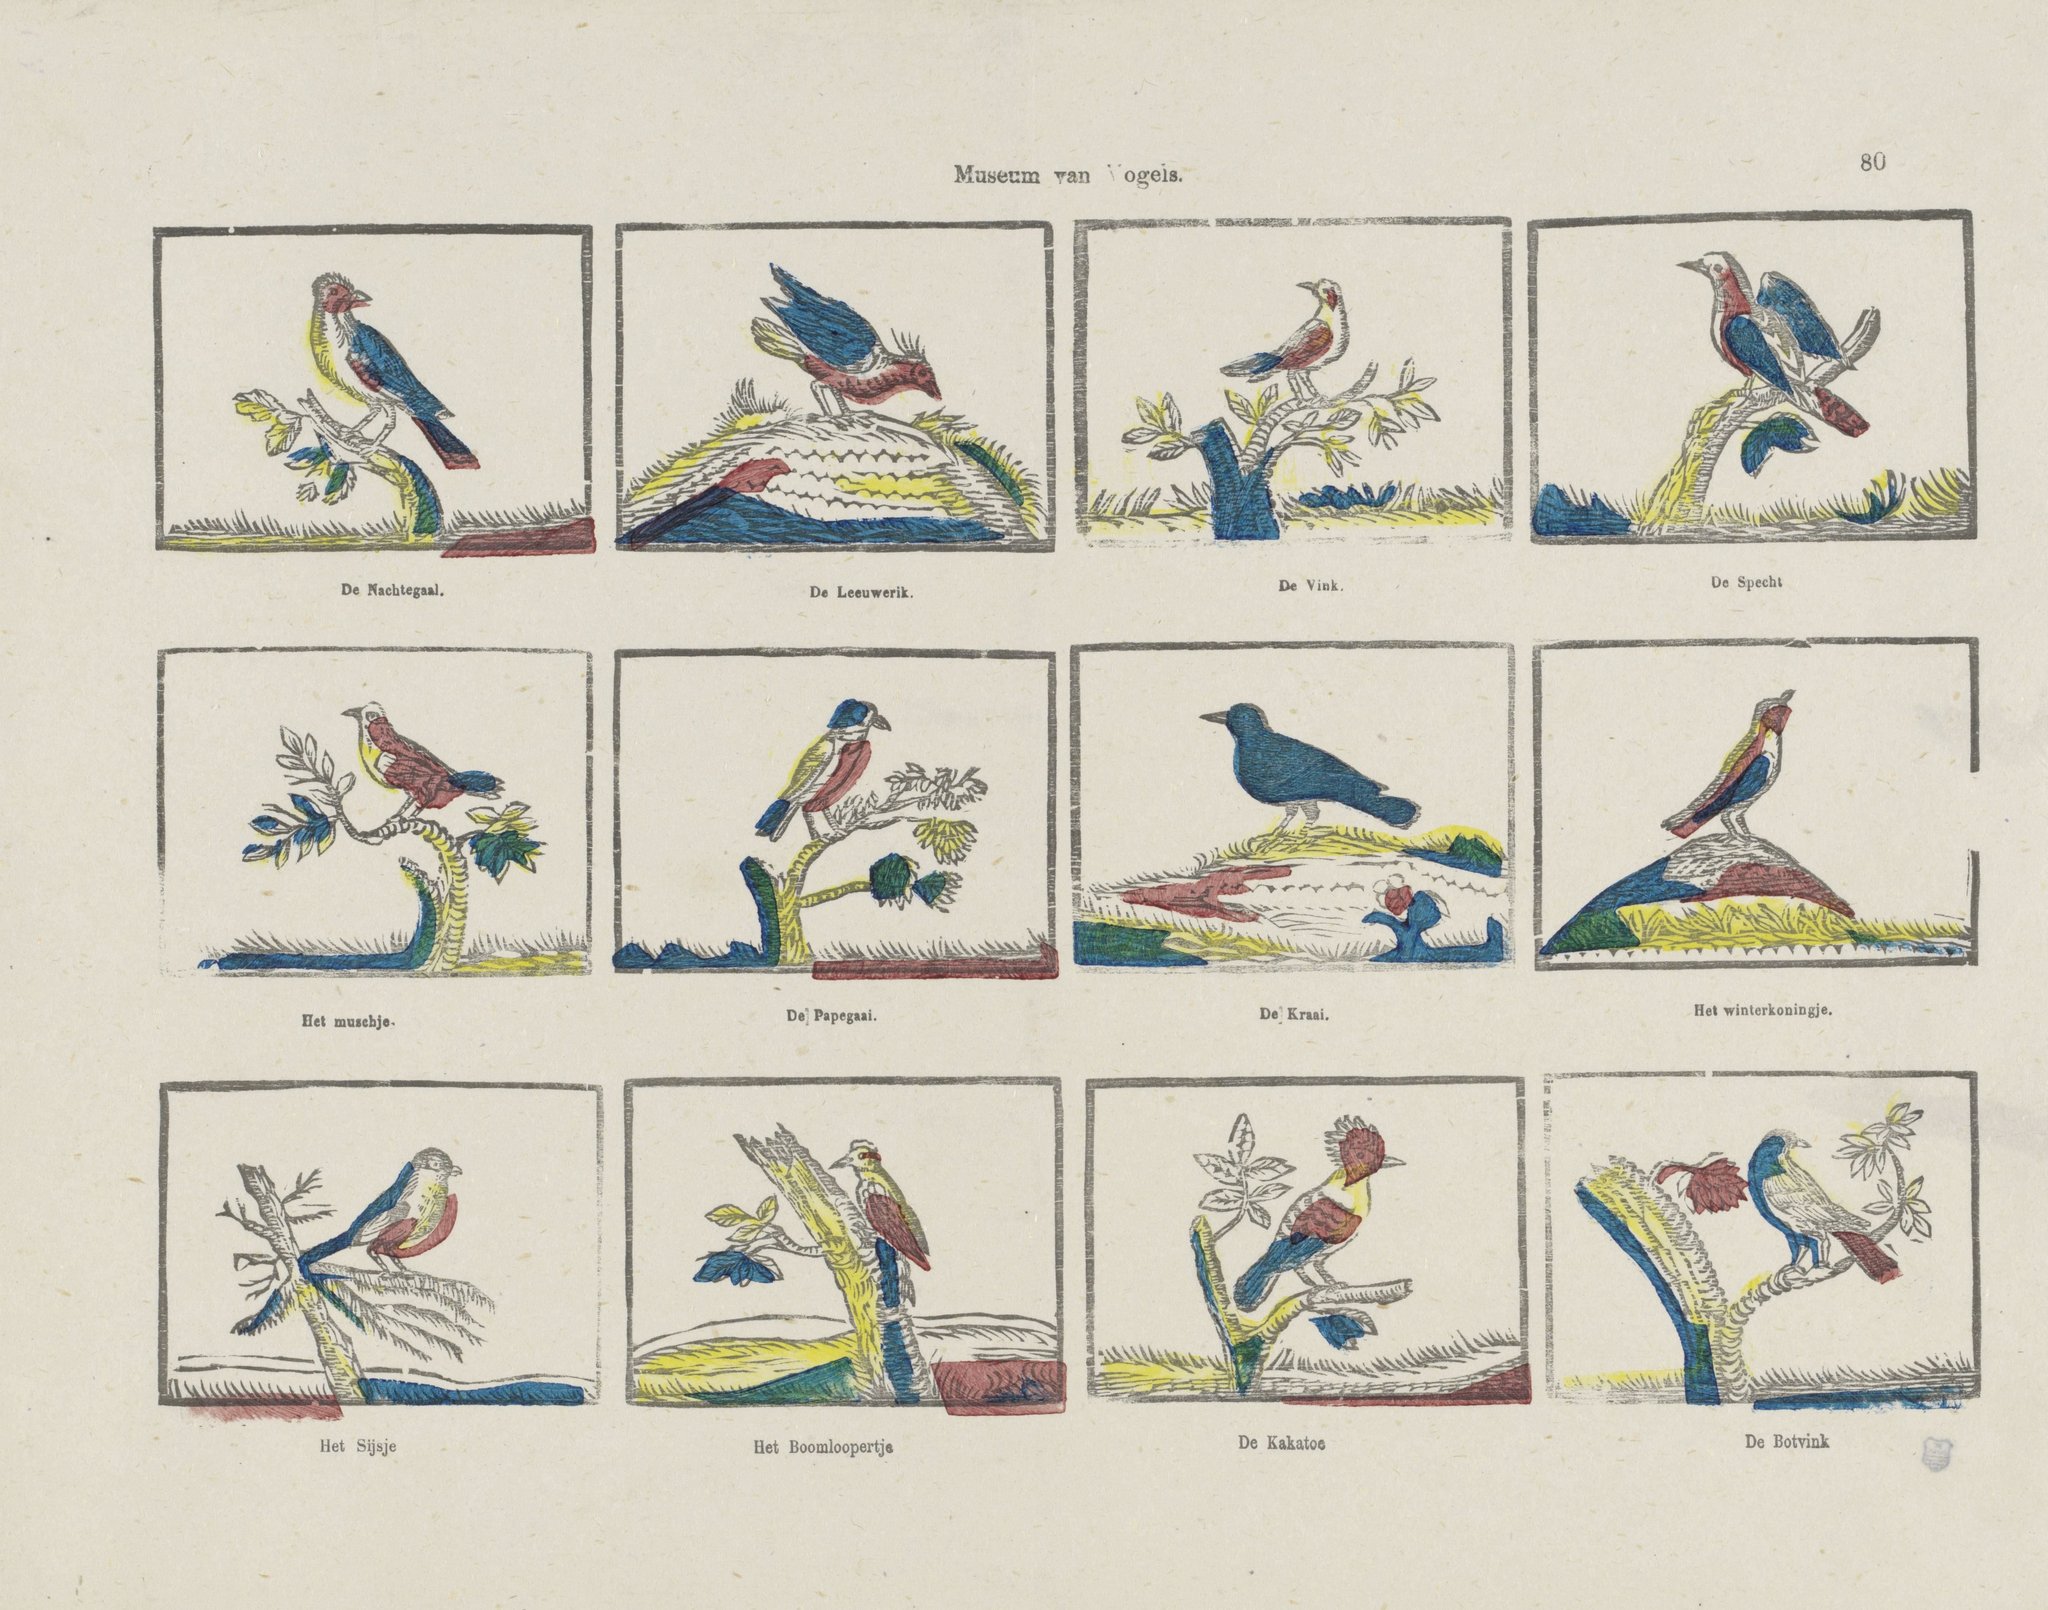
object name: print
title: Museum van vogels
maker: Anonymous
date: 1848-1881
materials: paper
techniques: colour, letterpress printing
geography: netherlands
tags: birds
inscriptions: collector's mark: Lugt 2760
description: Blad met 12 voorstellingen van vogels, zoals de nachtegaal, de vink en de specht. Onder elke afbeelding een onderschrift. Genummerd rechtsboven: 80.